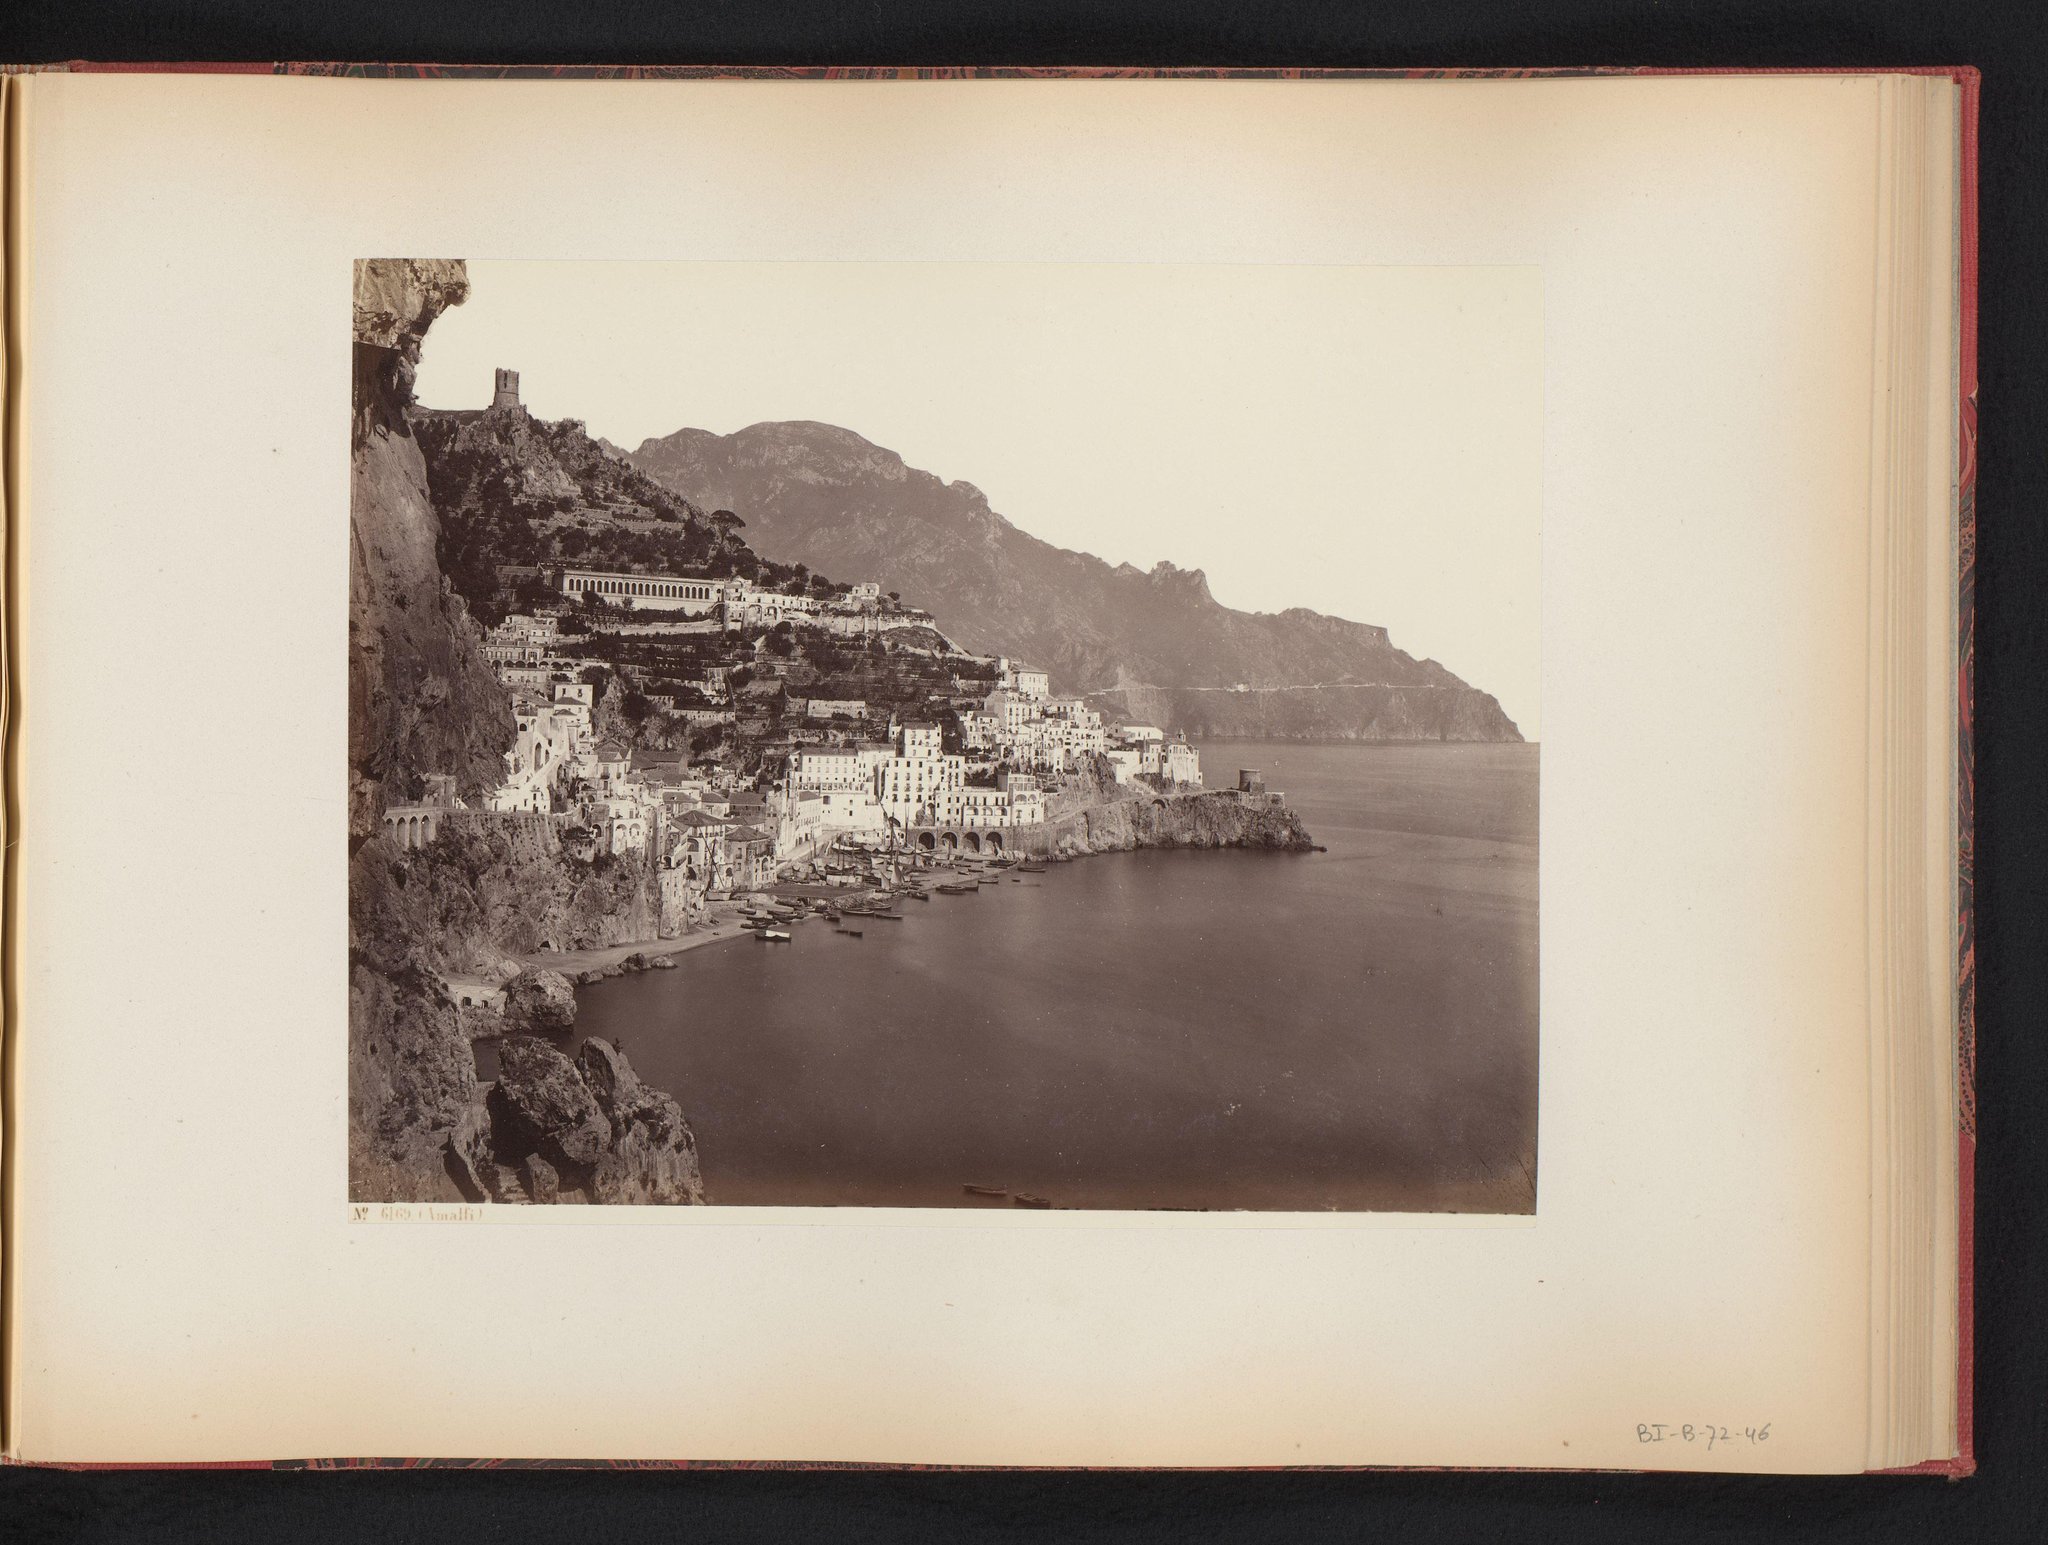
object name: photograph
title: Gezicht op Amalfi, Italië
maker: giorgio sommer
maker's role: fotograaf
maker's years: 1834-1914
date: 1870-1890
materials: paper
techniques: albumen print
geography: amalfi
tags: city-view in general; 'veduta', coast, amalfi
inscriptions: number: ‘No. 6169.’